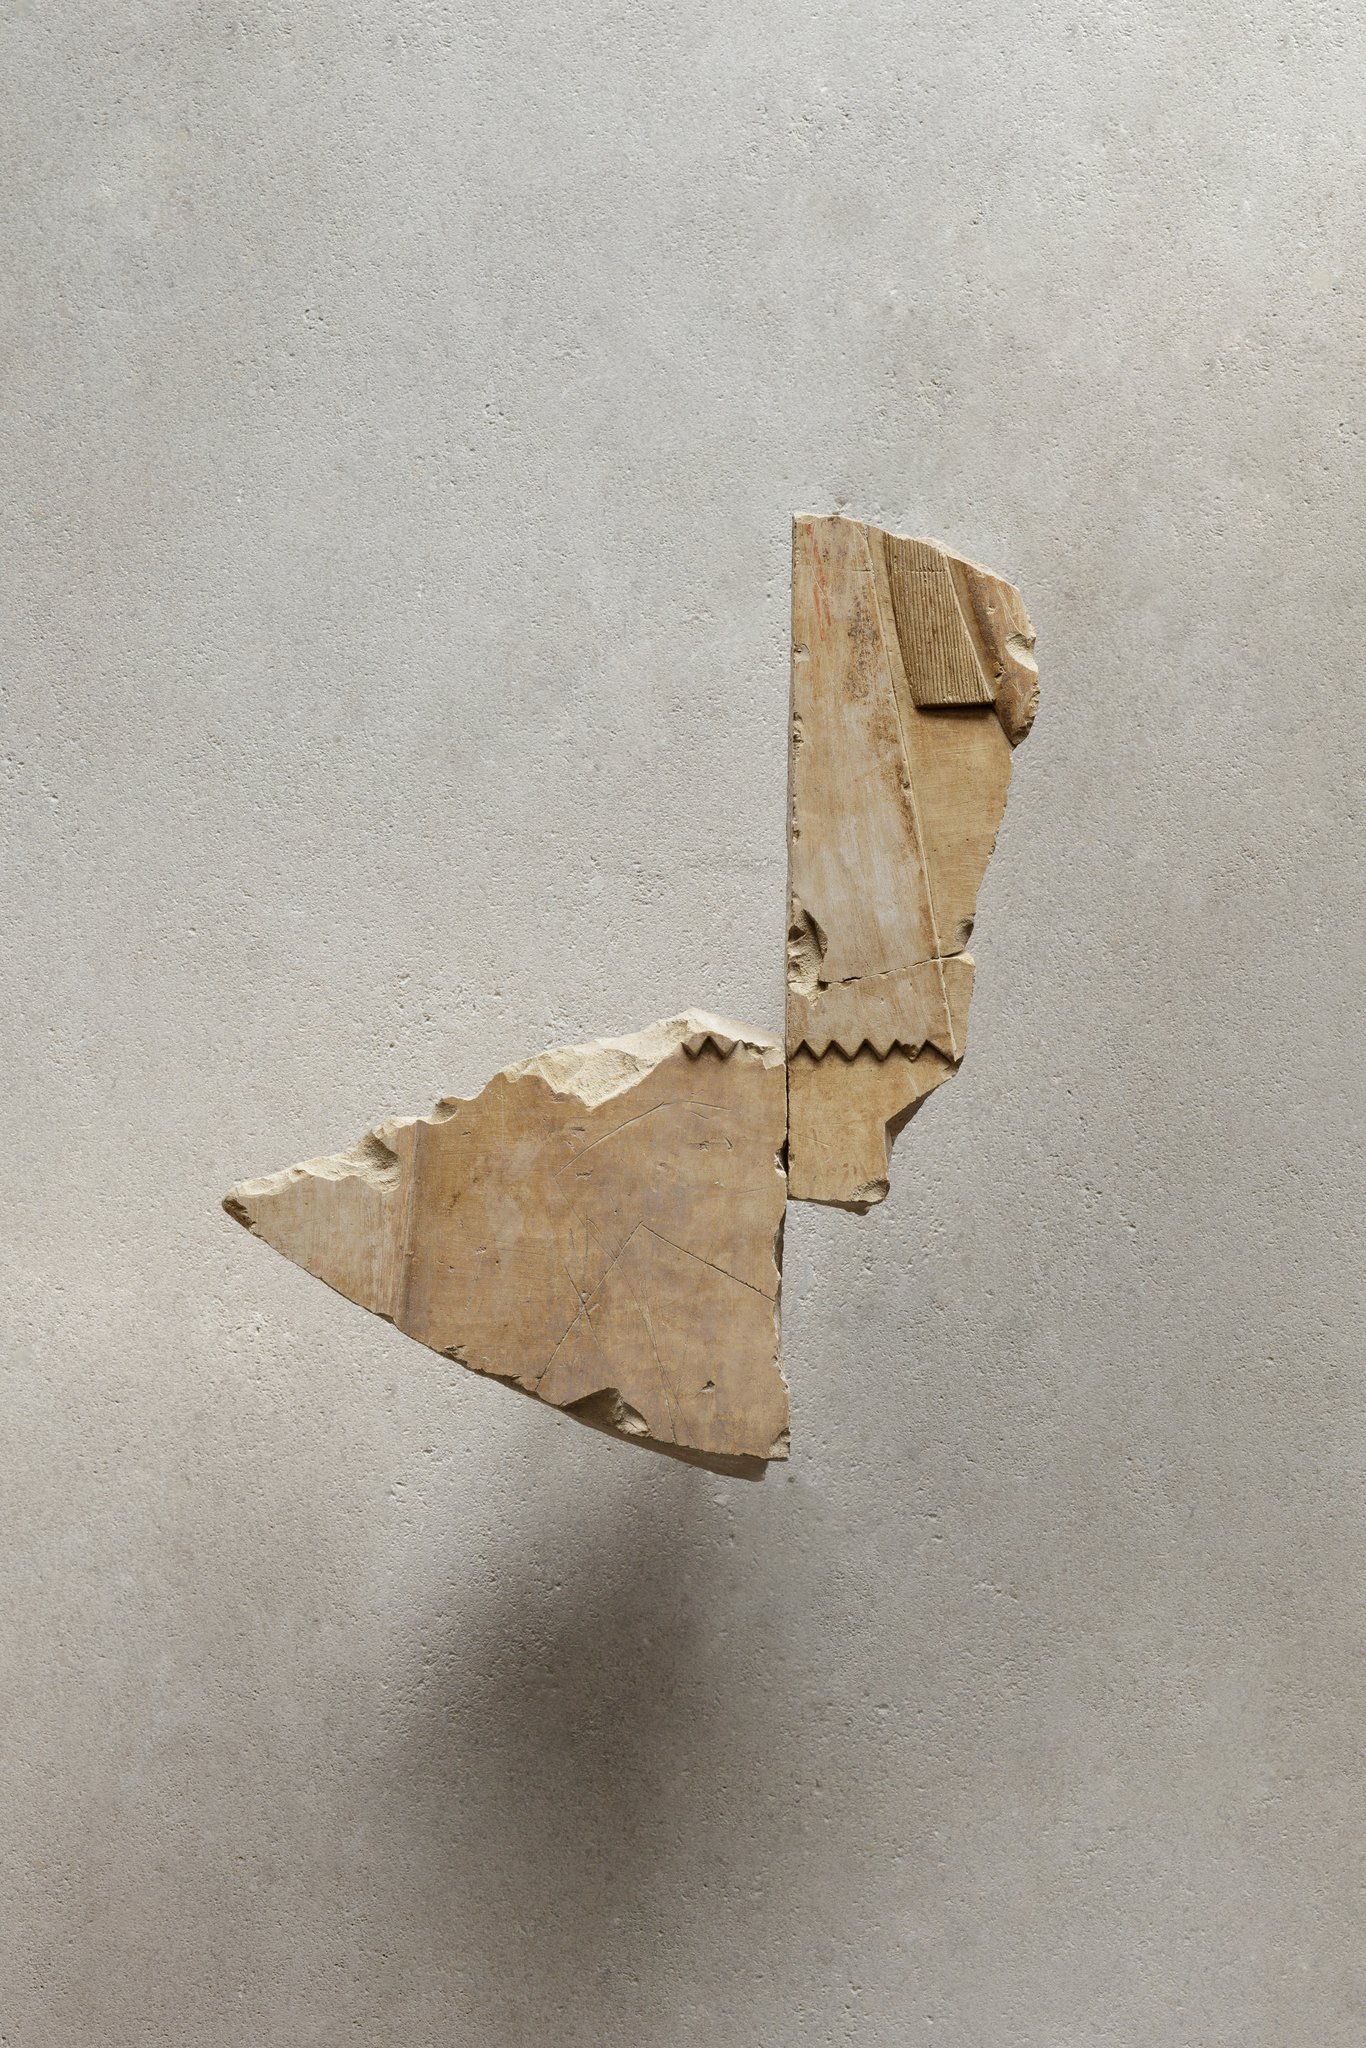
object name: relief fragment, tomb of neferu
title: Relief from the tomb of Queen Neferu: part of a sunshade (see 26.3.353-1)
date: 2051-2030 BCE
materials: limestone, paint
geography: egypt